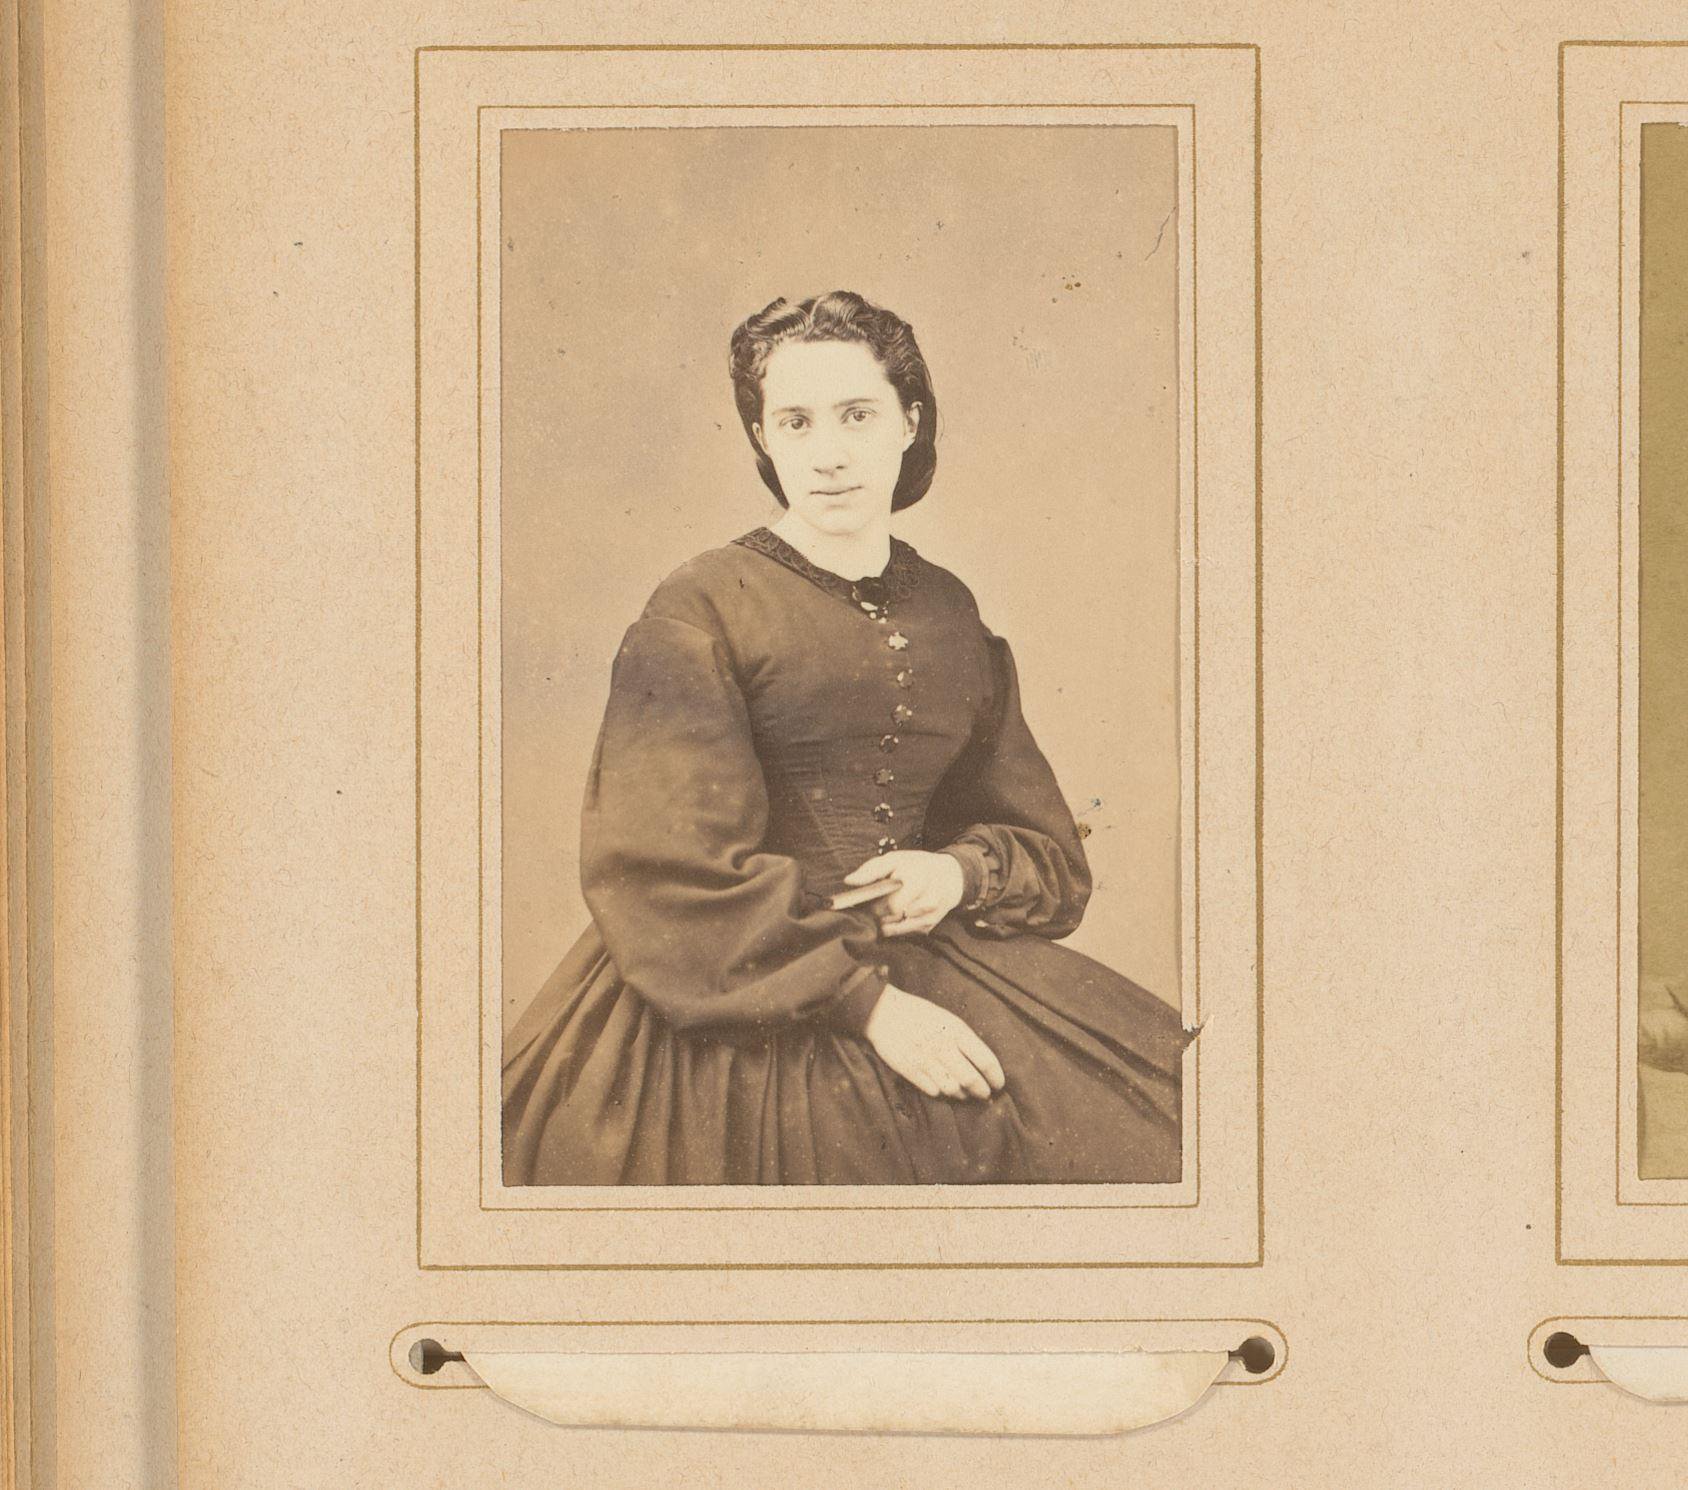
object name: carte de visite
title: Portret van een vrouw met boek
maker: Anonymous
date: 1855-1880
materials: cardboard, photographic support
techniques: albumen print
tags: historical persons - bb - woman